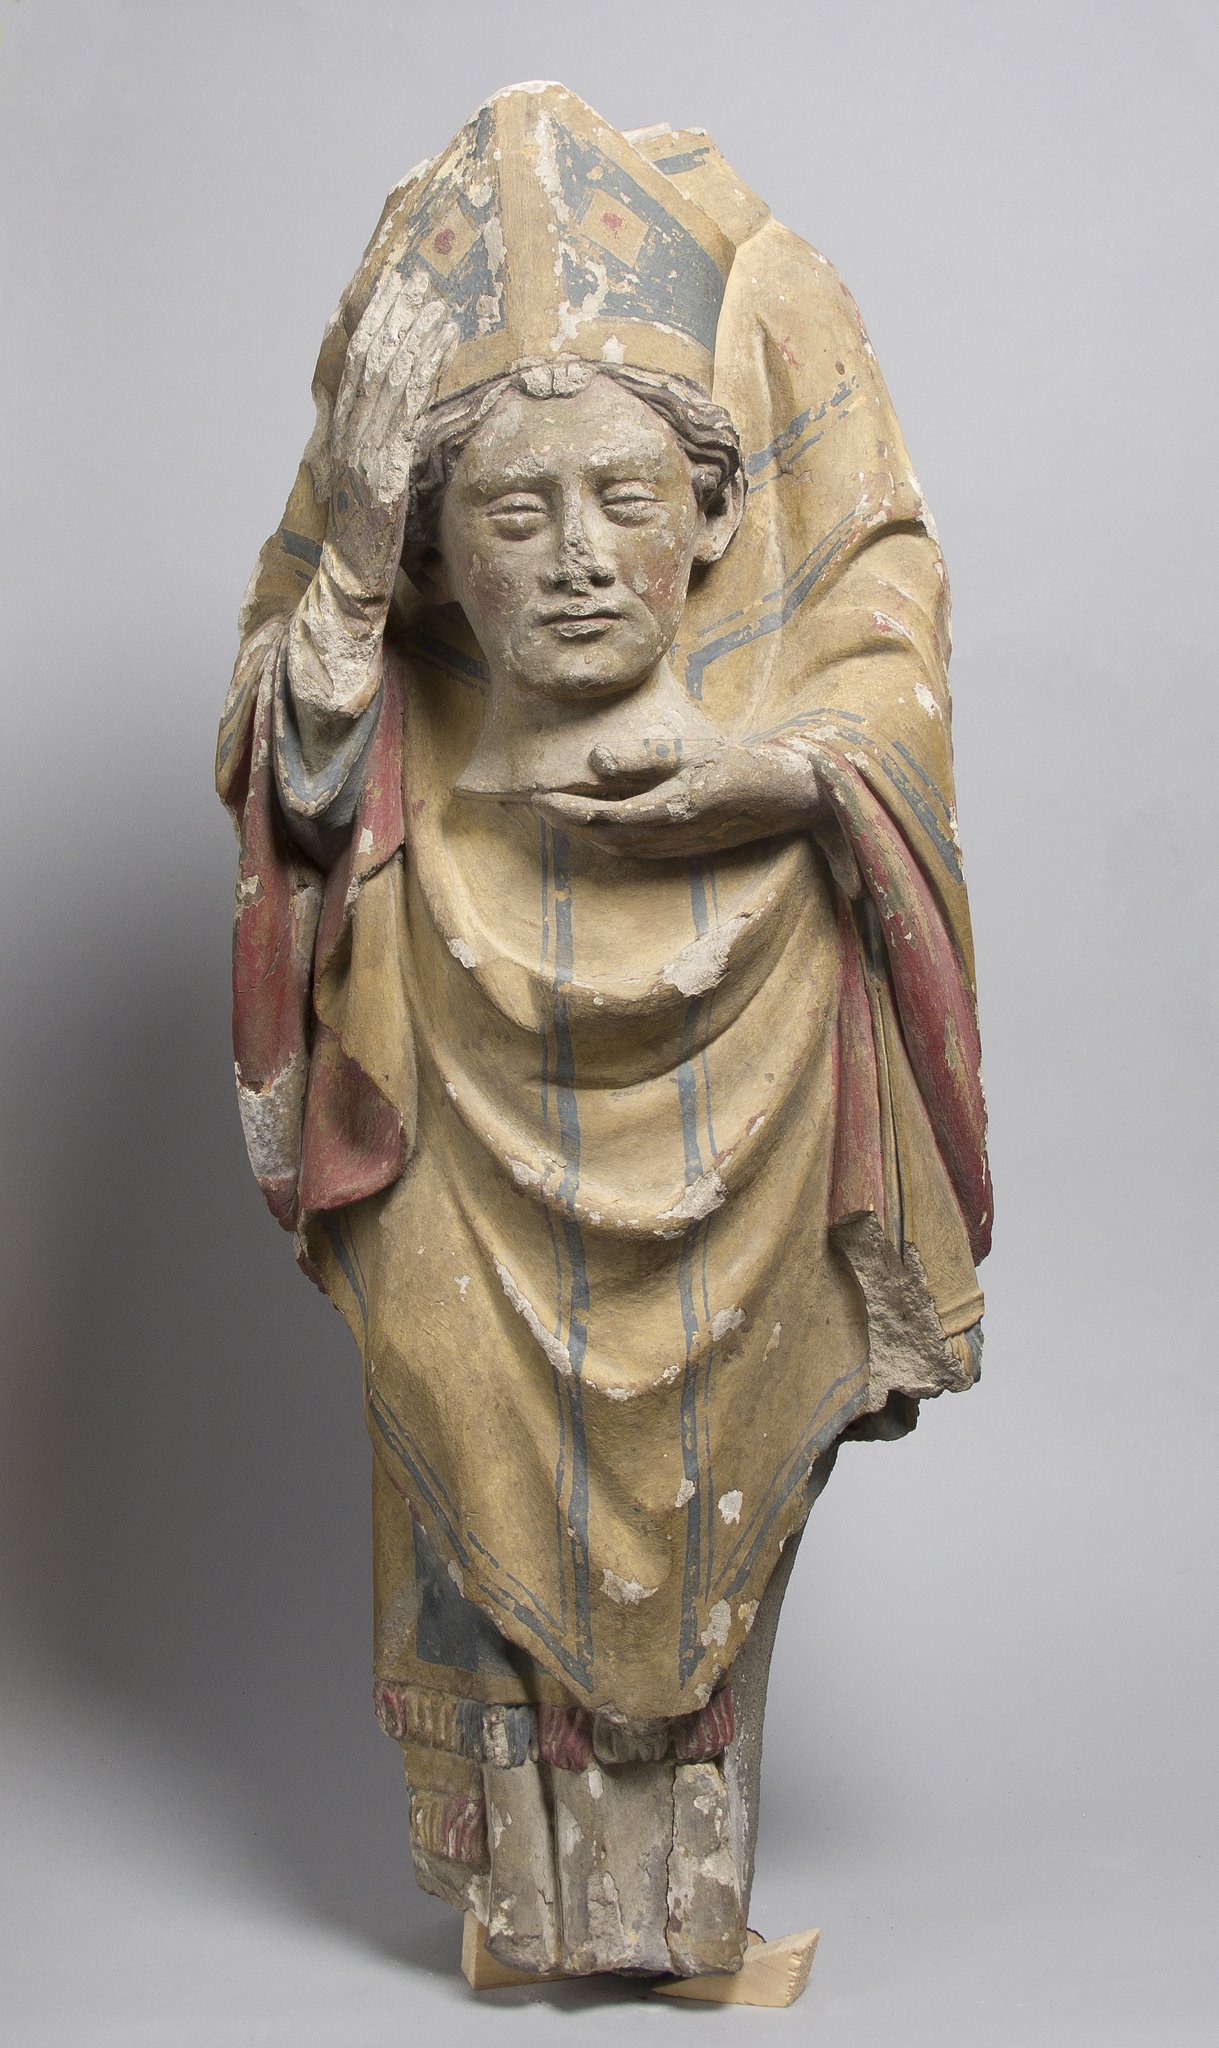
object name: statuette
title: Saint Denis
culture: french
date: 1301-1400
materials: paint, stone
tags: heads,saints